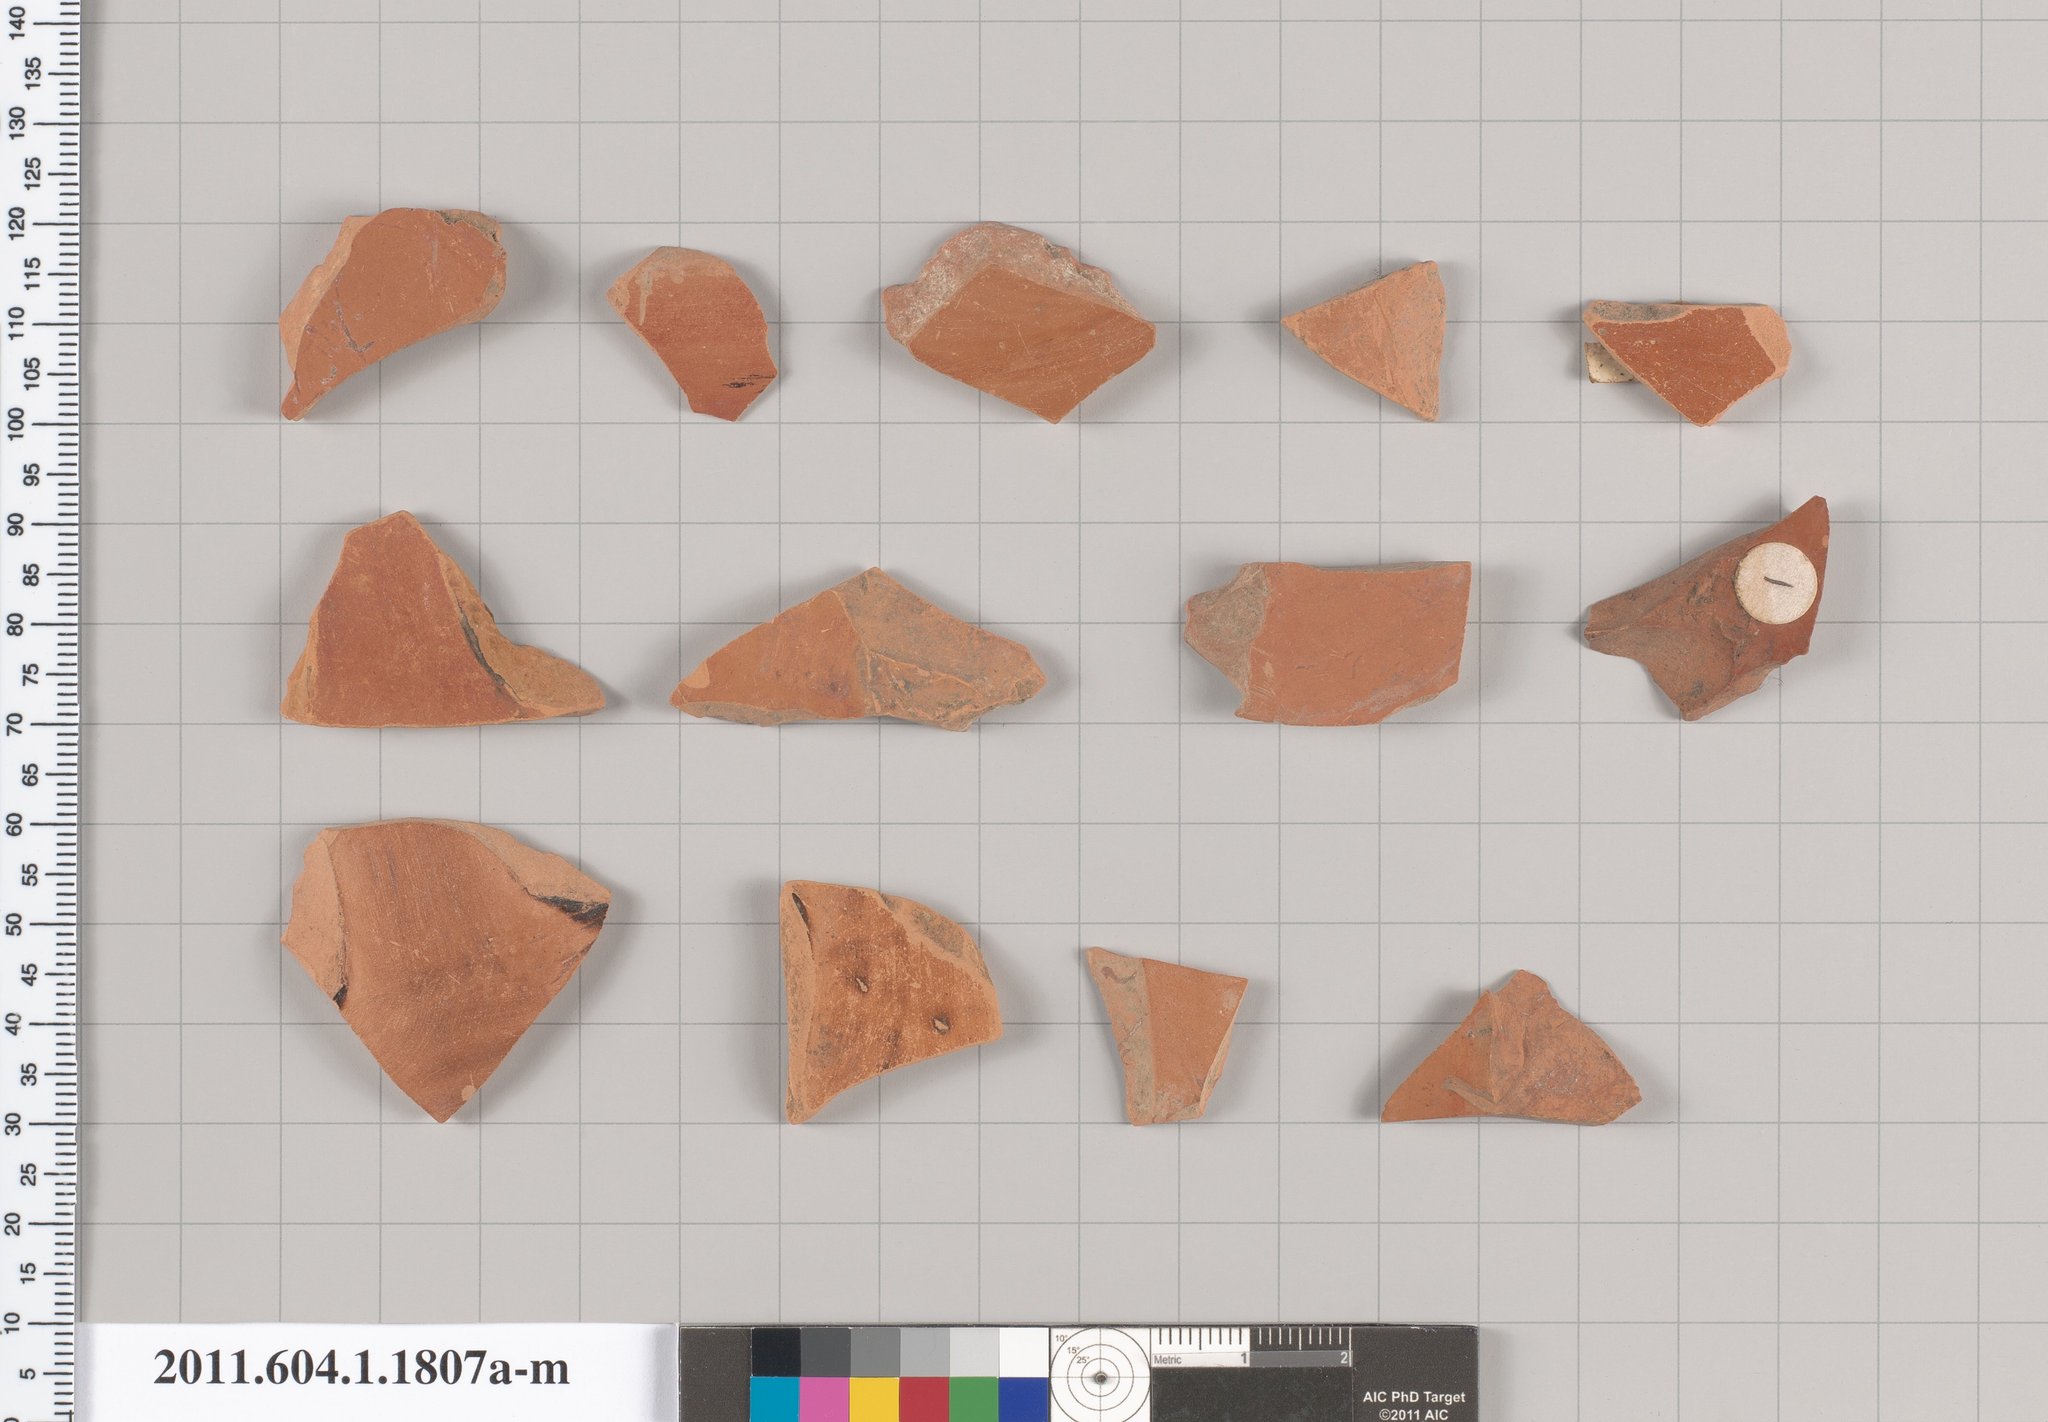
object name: kylix fragment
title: Terracotta rim fragments of kylikes(drinking cups)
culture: greek, attic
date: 500-401 BCE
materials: terracotta